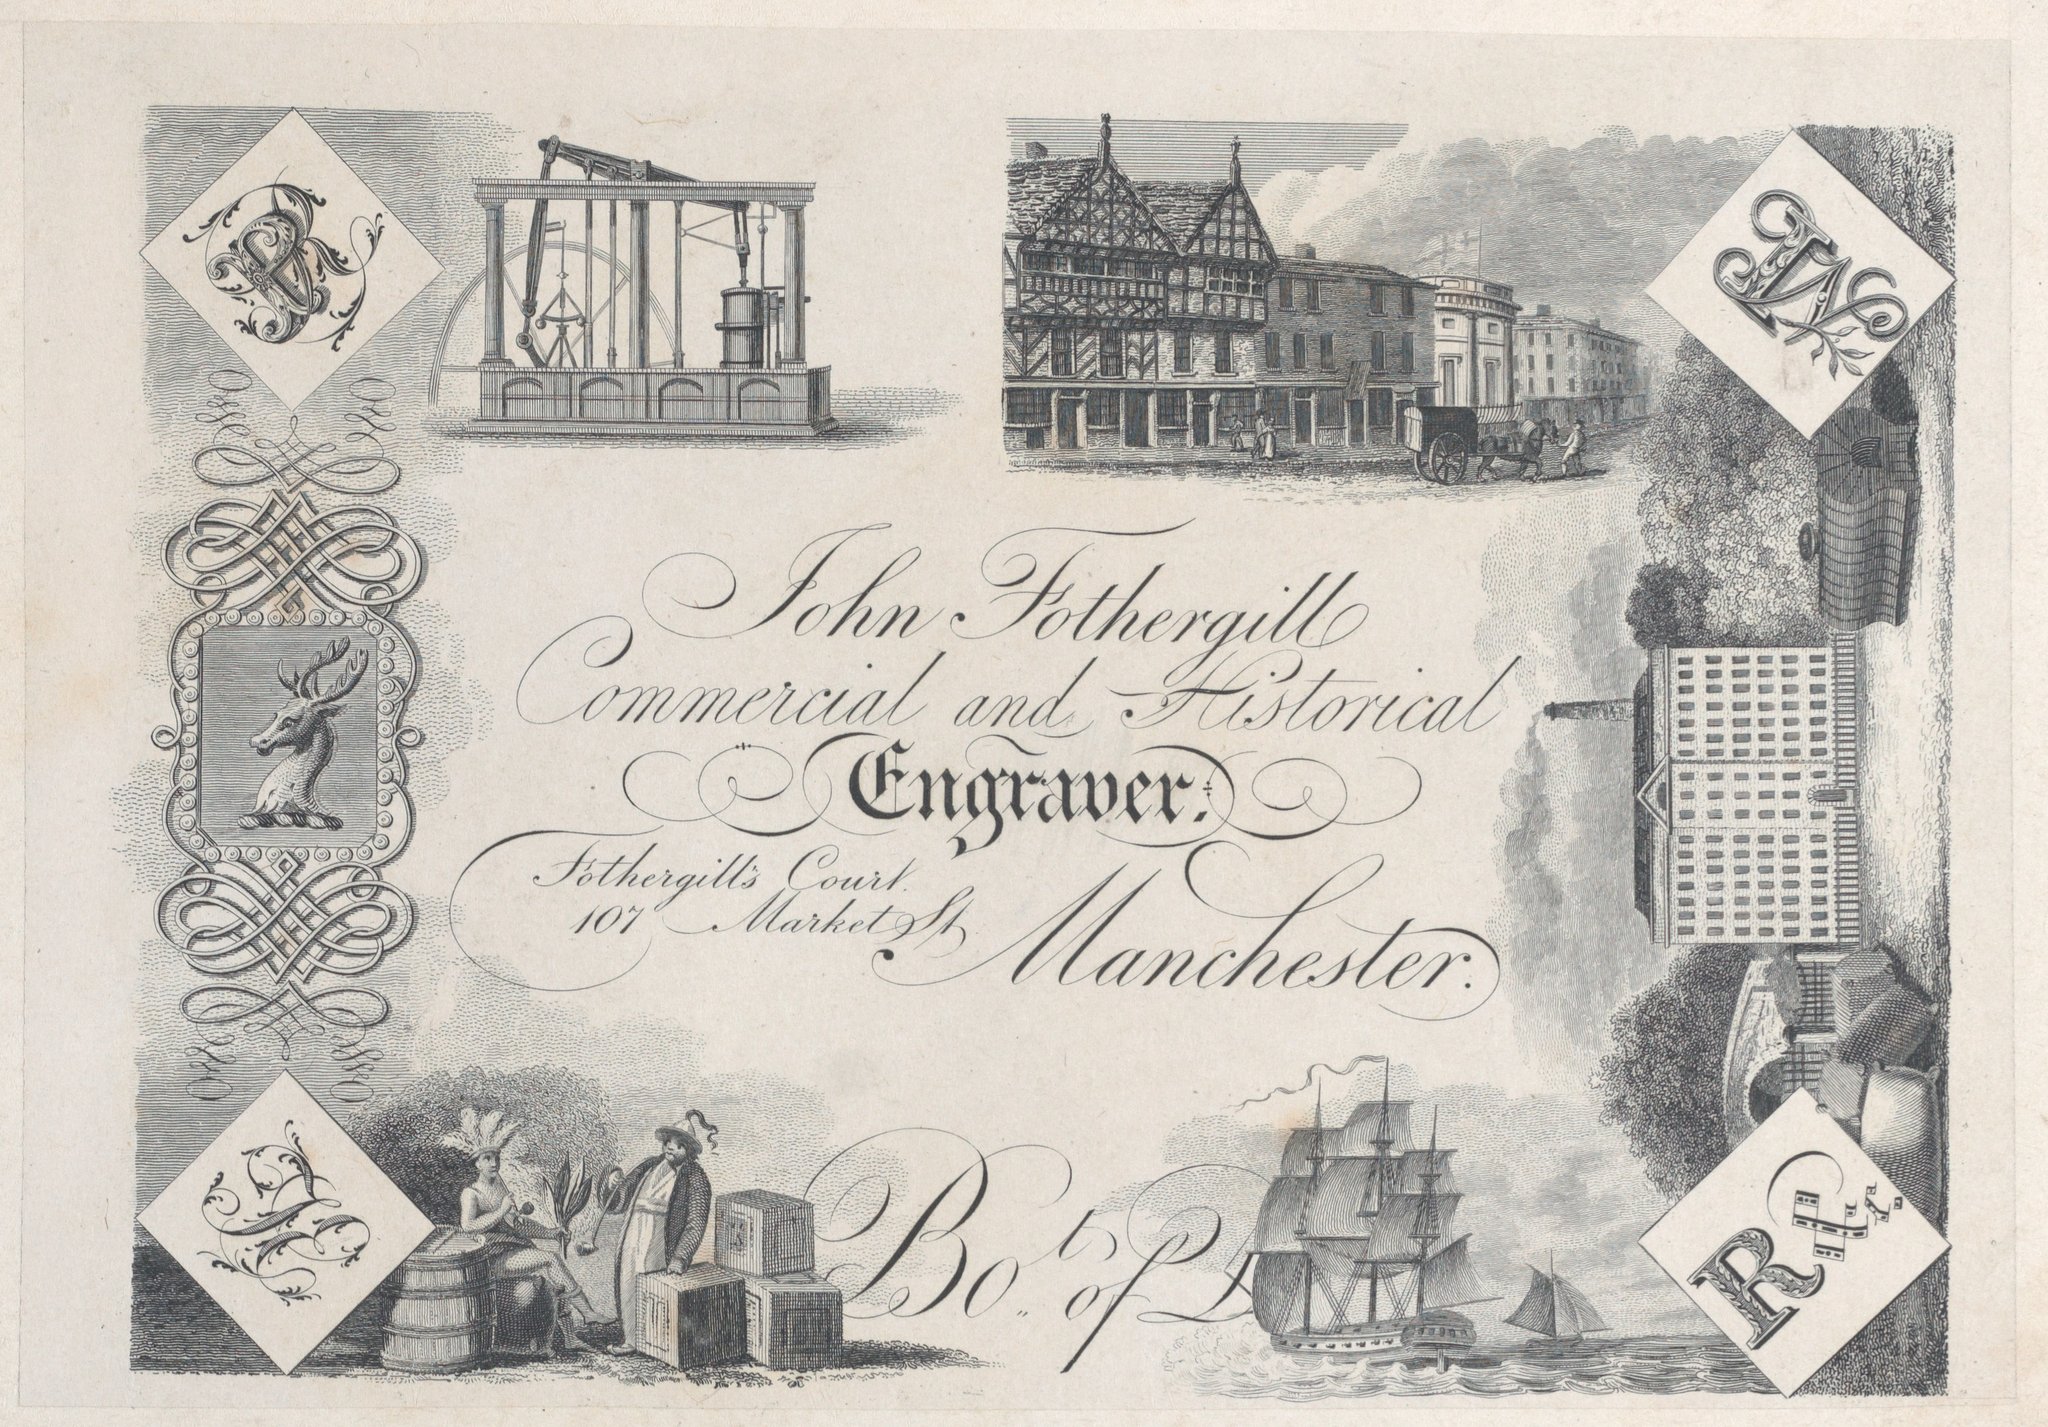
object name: print, trade card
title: Trade Card for John Fothergill, Commercial and Historical Engraver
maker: anonymous, british, 19th century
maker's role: artist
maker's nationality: british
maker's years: 1800-1900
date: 1801-1900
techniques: printmaking, engraving